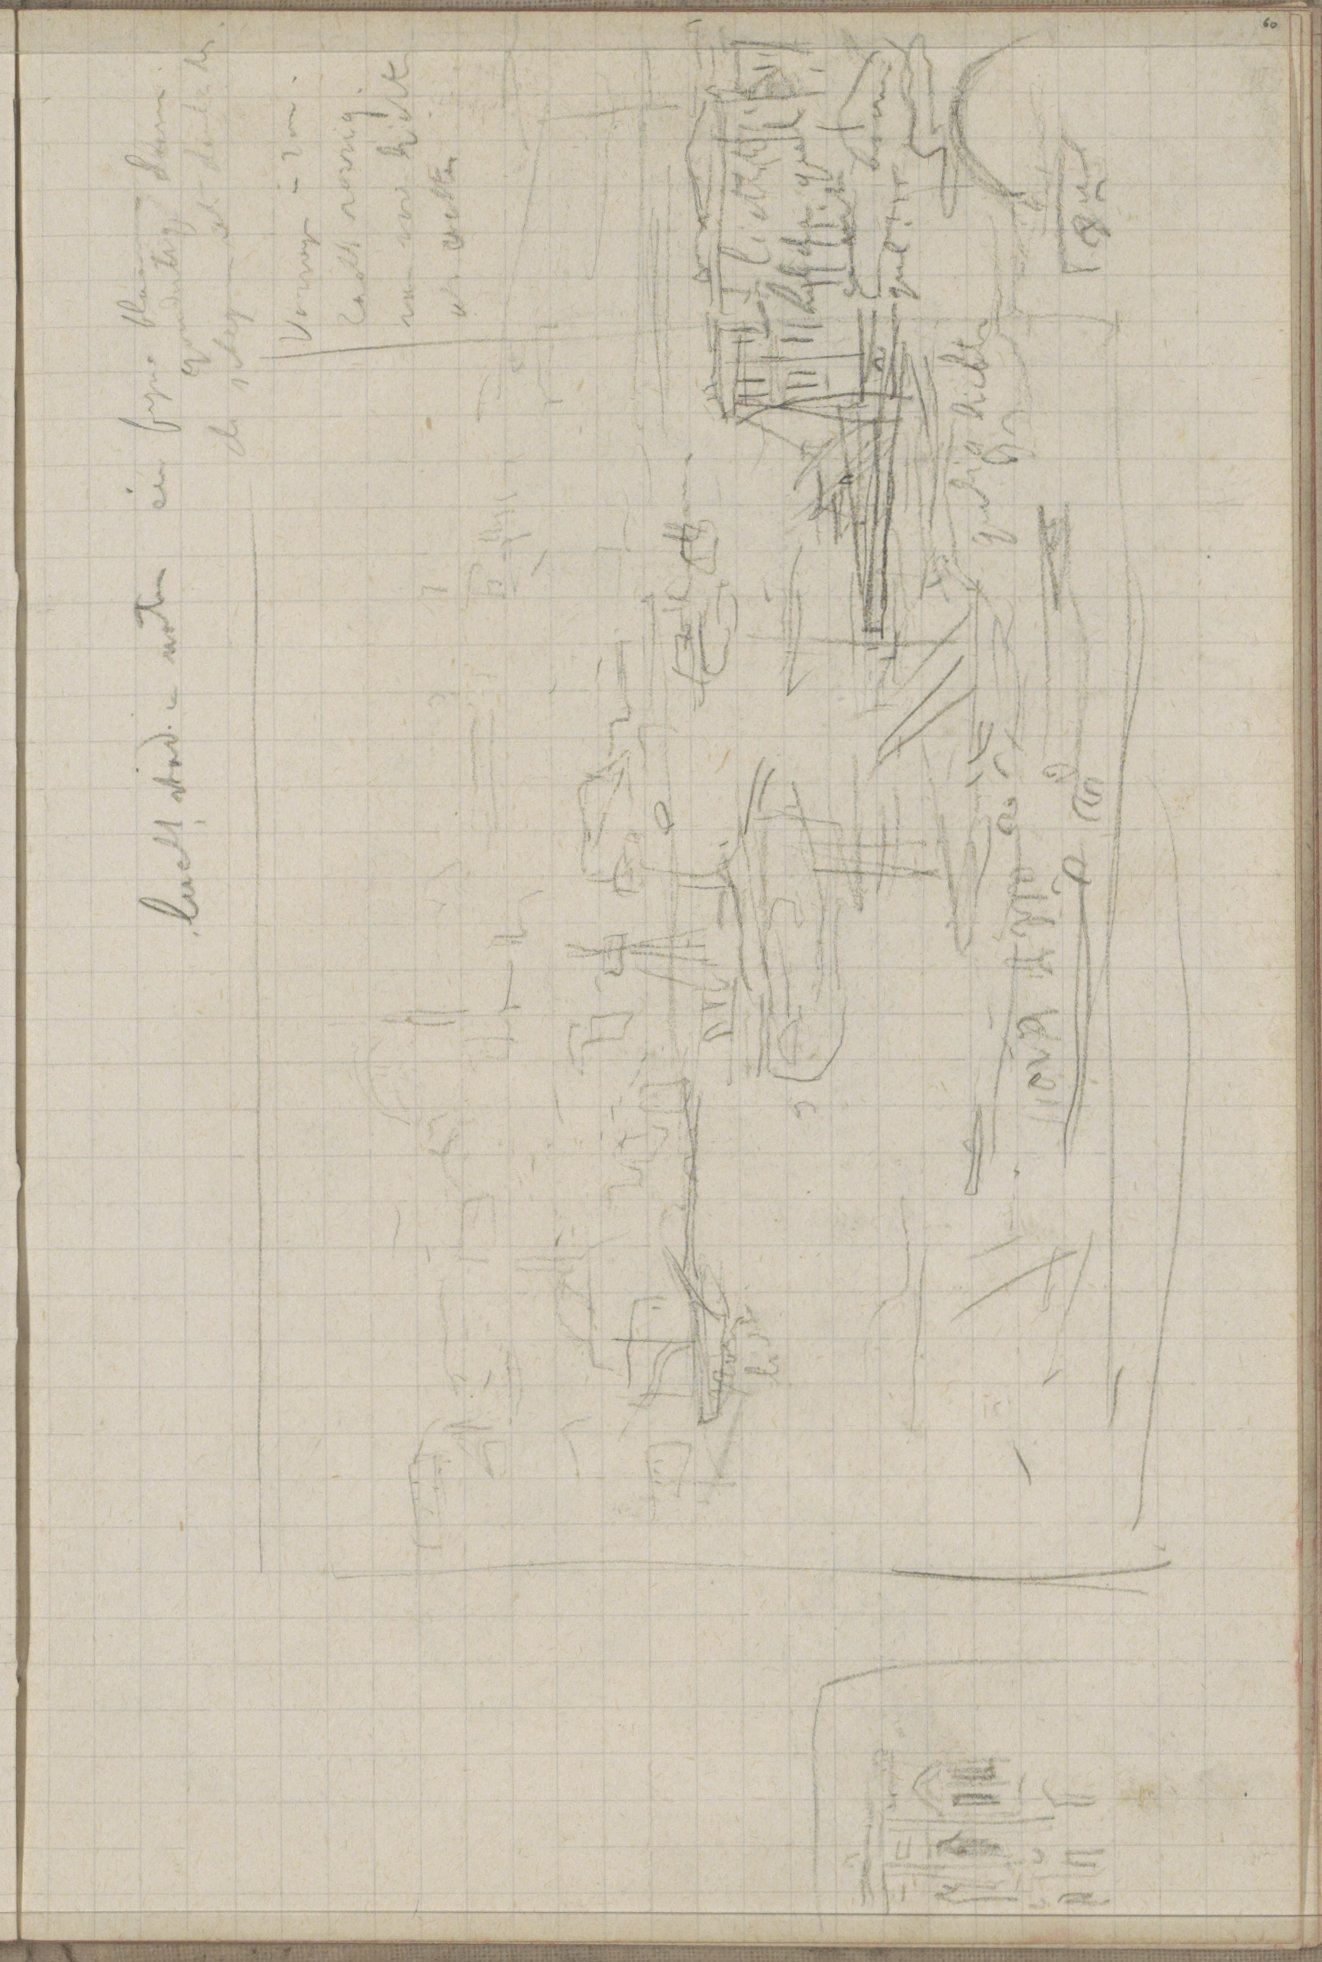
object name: sketchbook leaf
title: Gezicht op een stad en baai met schepen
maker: marius bauer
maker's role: draughtsman, print maker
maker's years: 1867-1932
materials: chalk, paper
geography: istanbul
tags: harbour, city-view, and landscape with man-made constructions, landscapes with waters, waterscapes, seascapes (in the temperate zone)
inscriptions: kleurnotitie, handgeschreven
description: Vermoedelijk de haven van Constantinopel. Pagina 60 uit een schetsboek met 51 bladen.